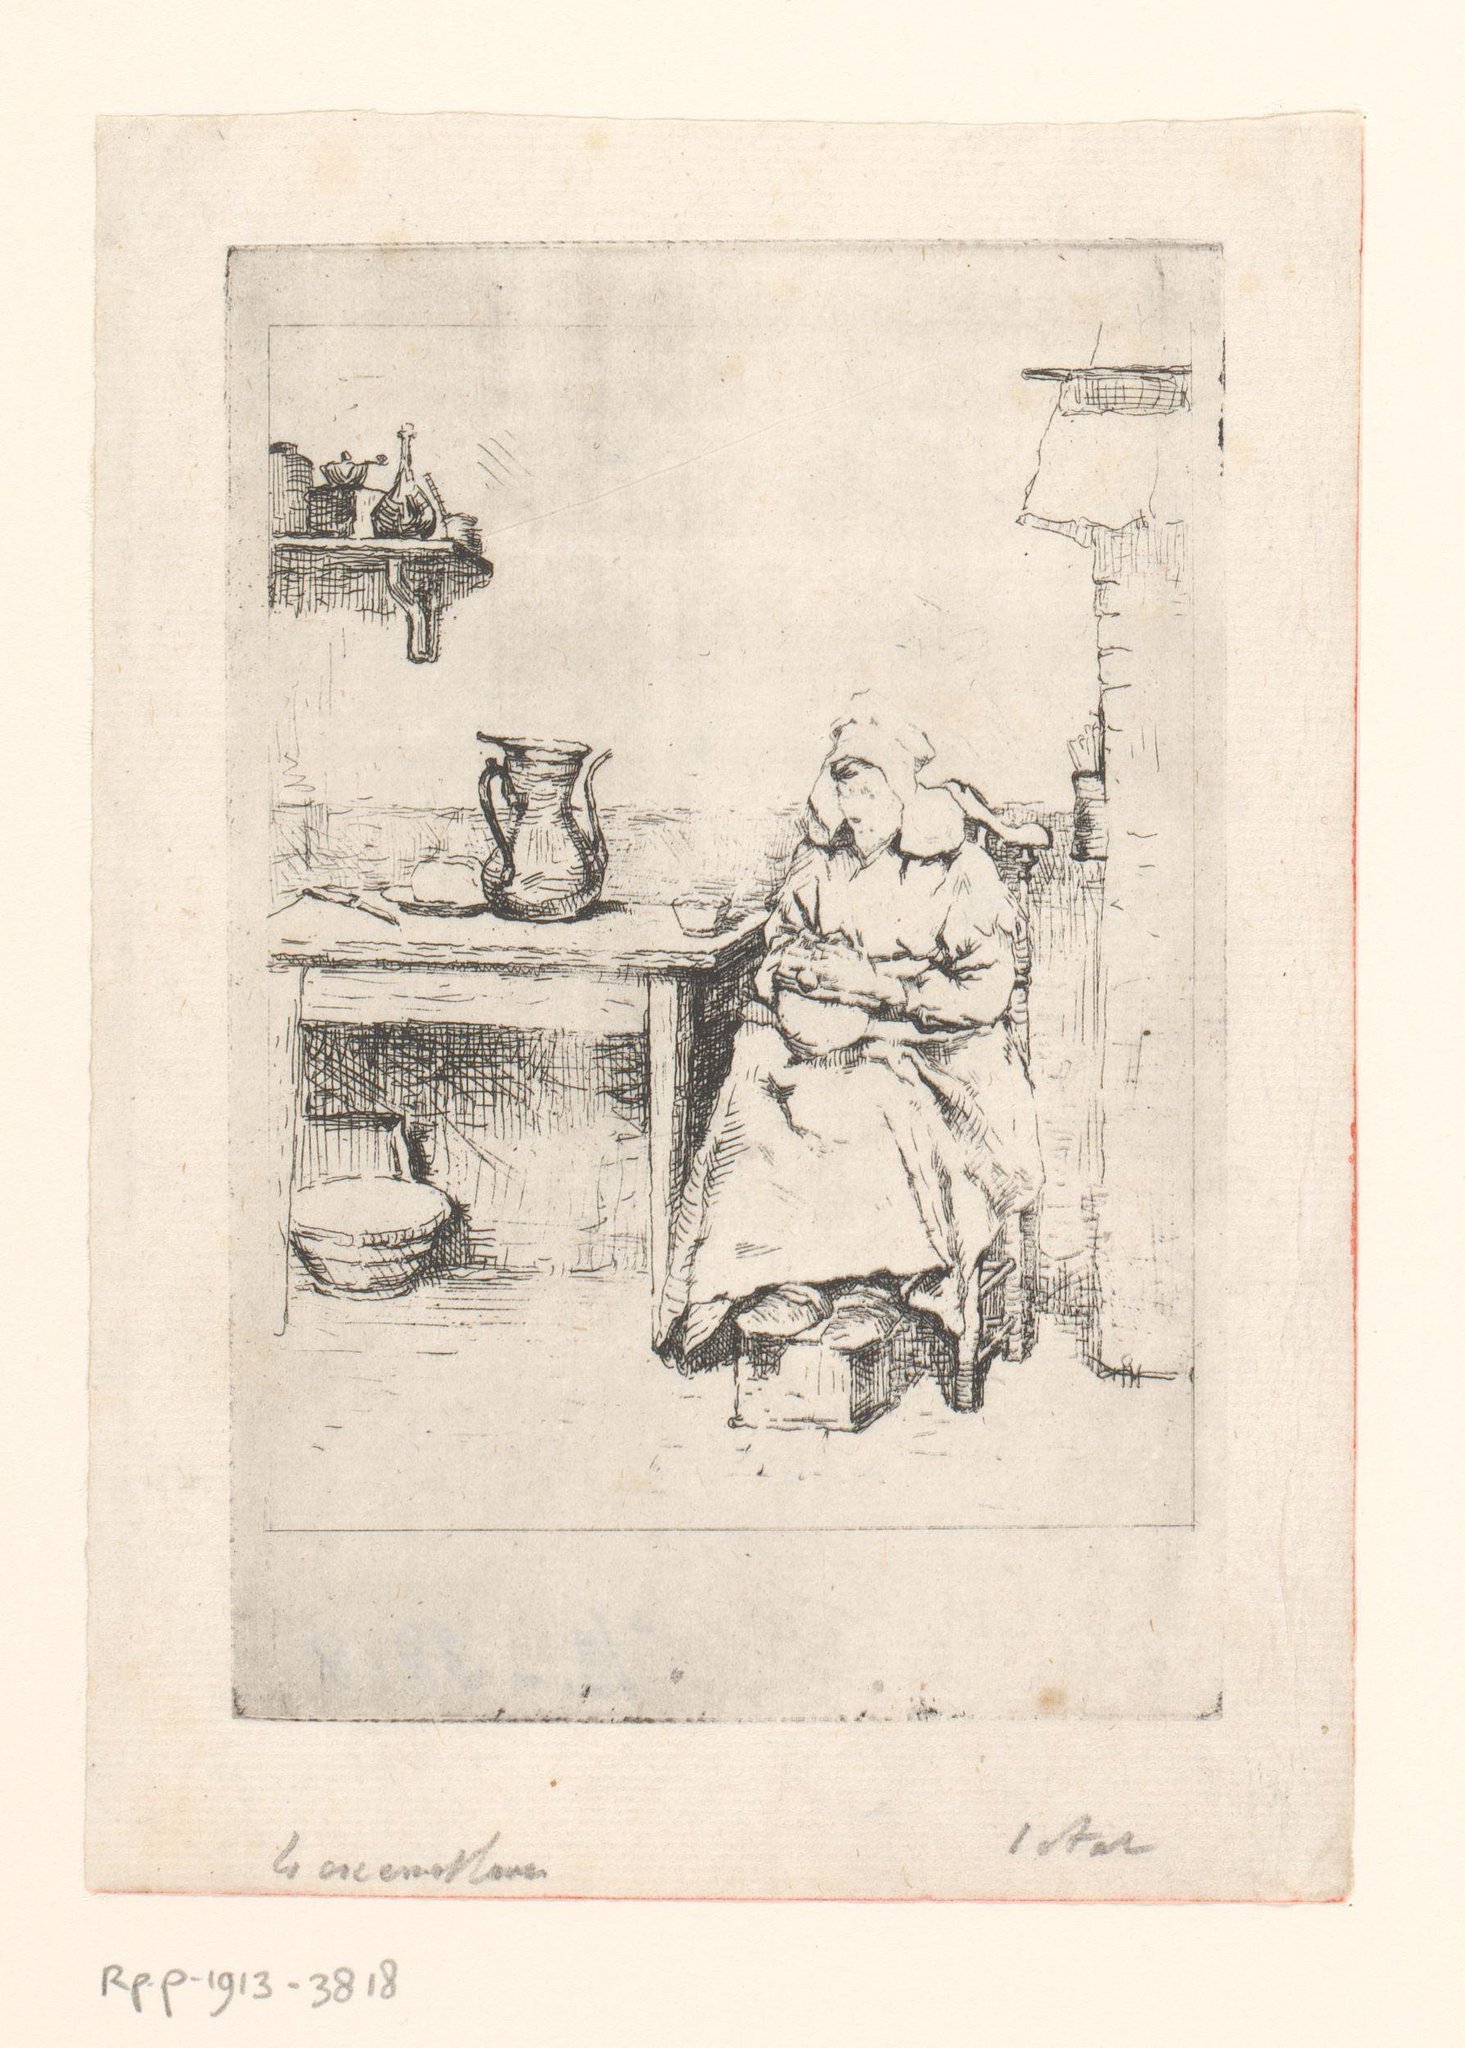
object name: print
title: Interieur met schillende boerin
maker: piet verhaert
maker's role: print maker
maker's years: 1852-1908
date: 1879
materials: paper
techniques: etching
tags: farmers - aa - female farmer, farmer's wife, interior of the house, cleaning (food)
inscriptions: inscription: ‘4 exemplares; 1 etat’, collector's mark: Lugt 2228